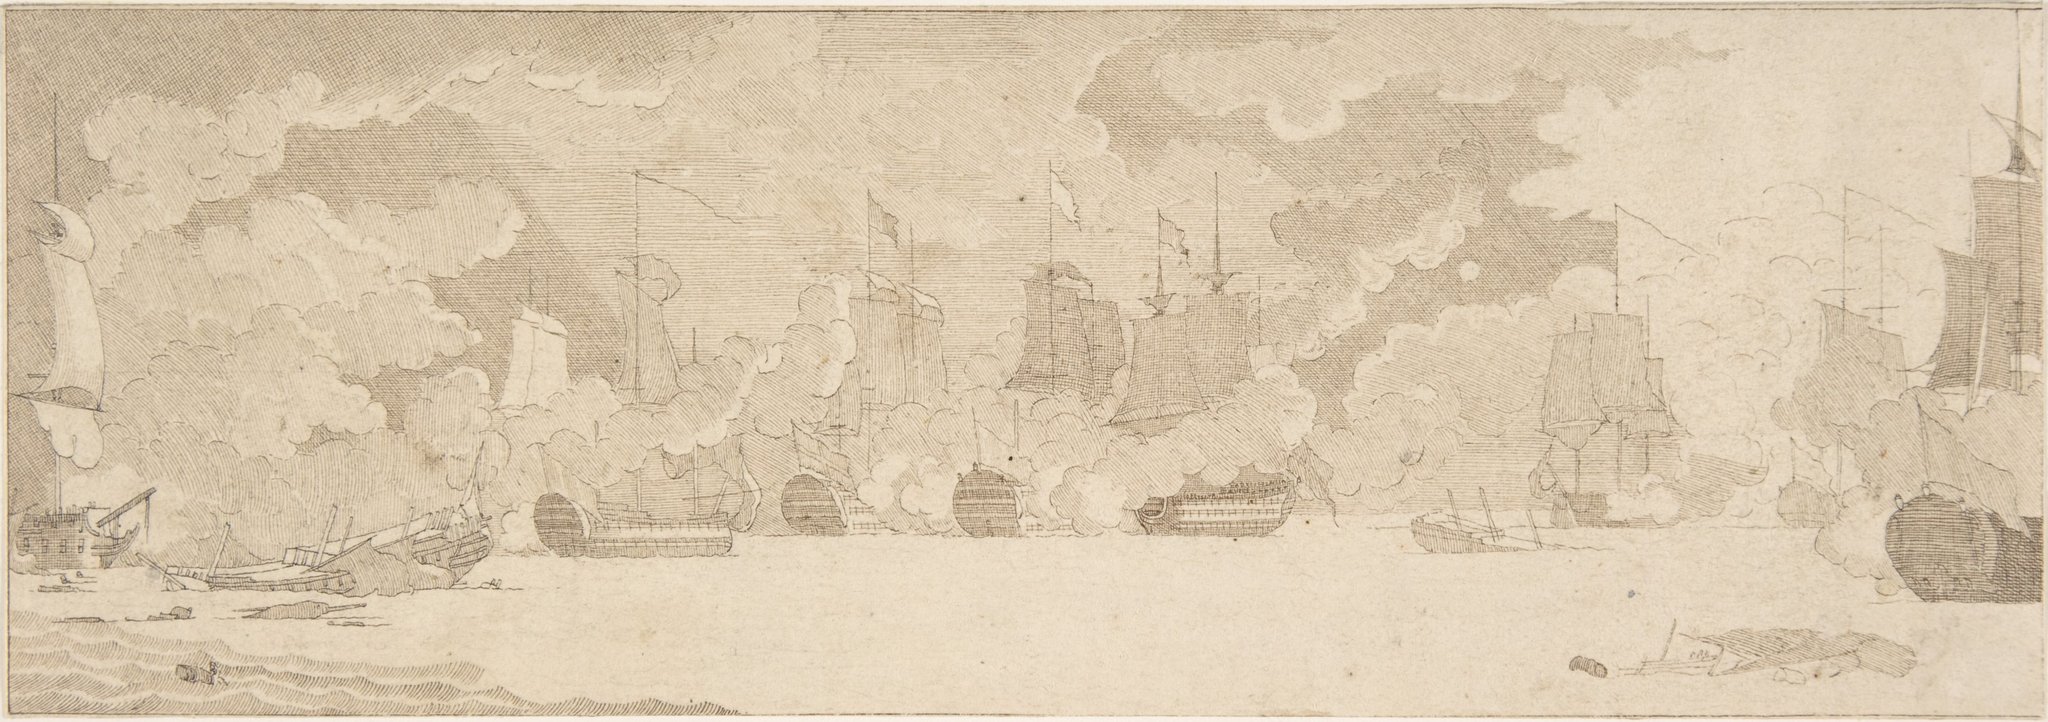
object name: drawing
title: Sea Battle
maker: anonymous, dutch, 17th century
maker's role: artist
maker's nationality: dutch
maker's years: 1600-1700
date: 1601-1700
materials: ink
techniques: pen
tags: battles,ships